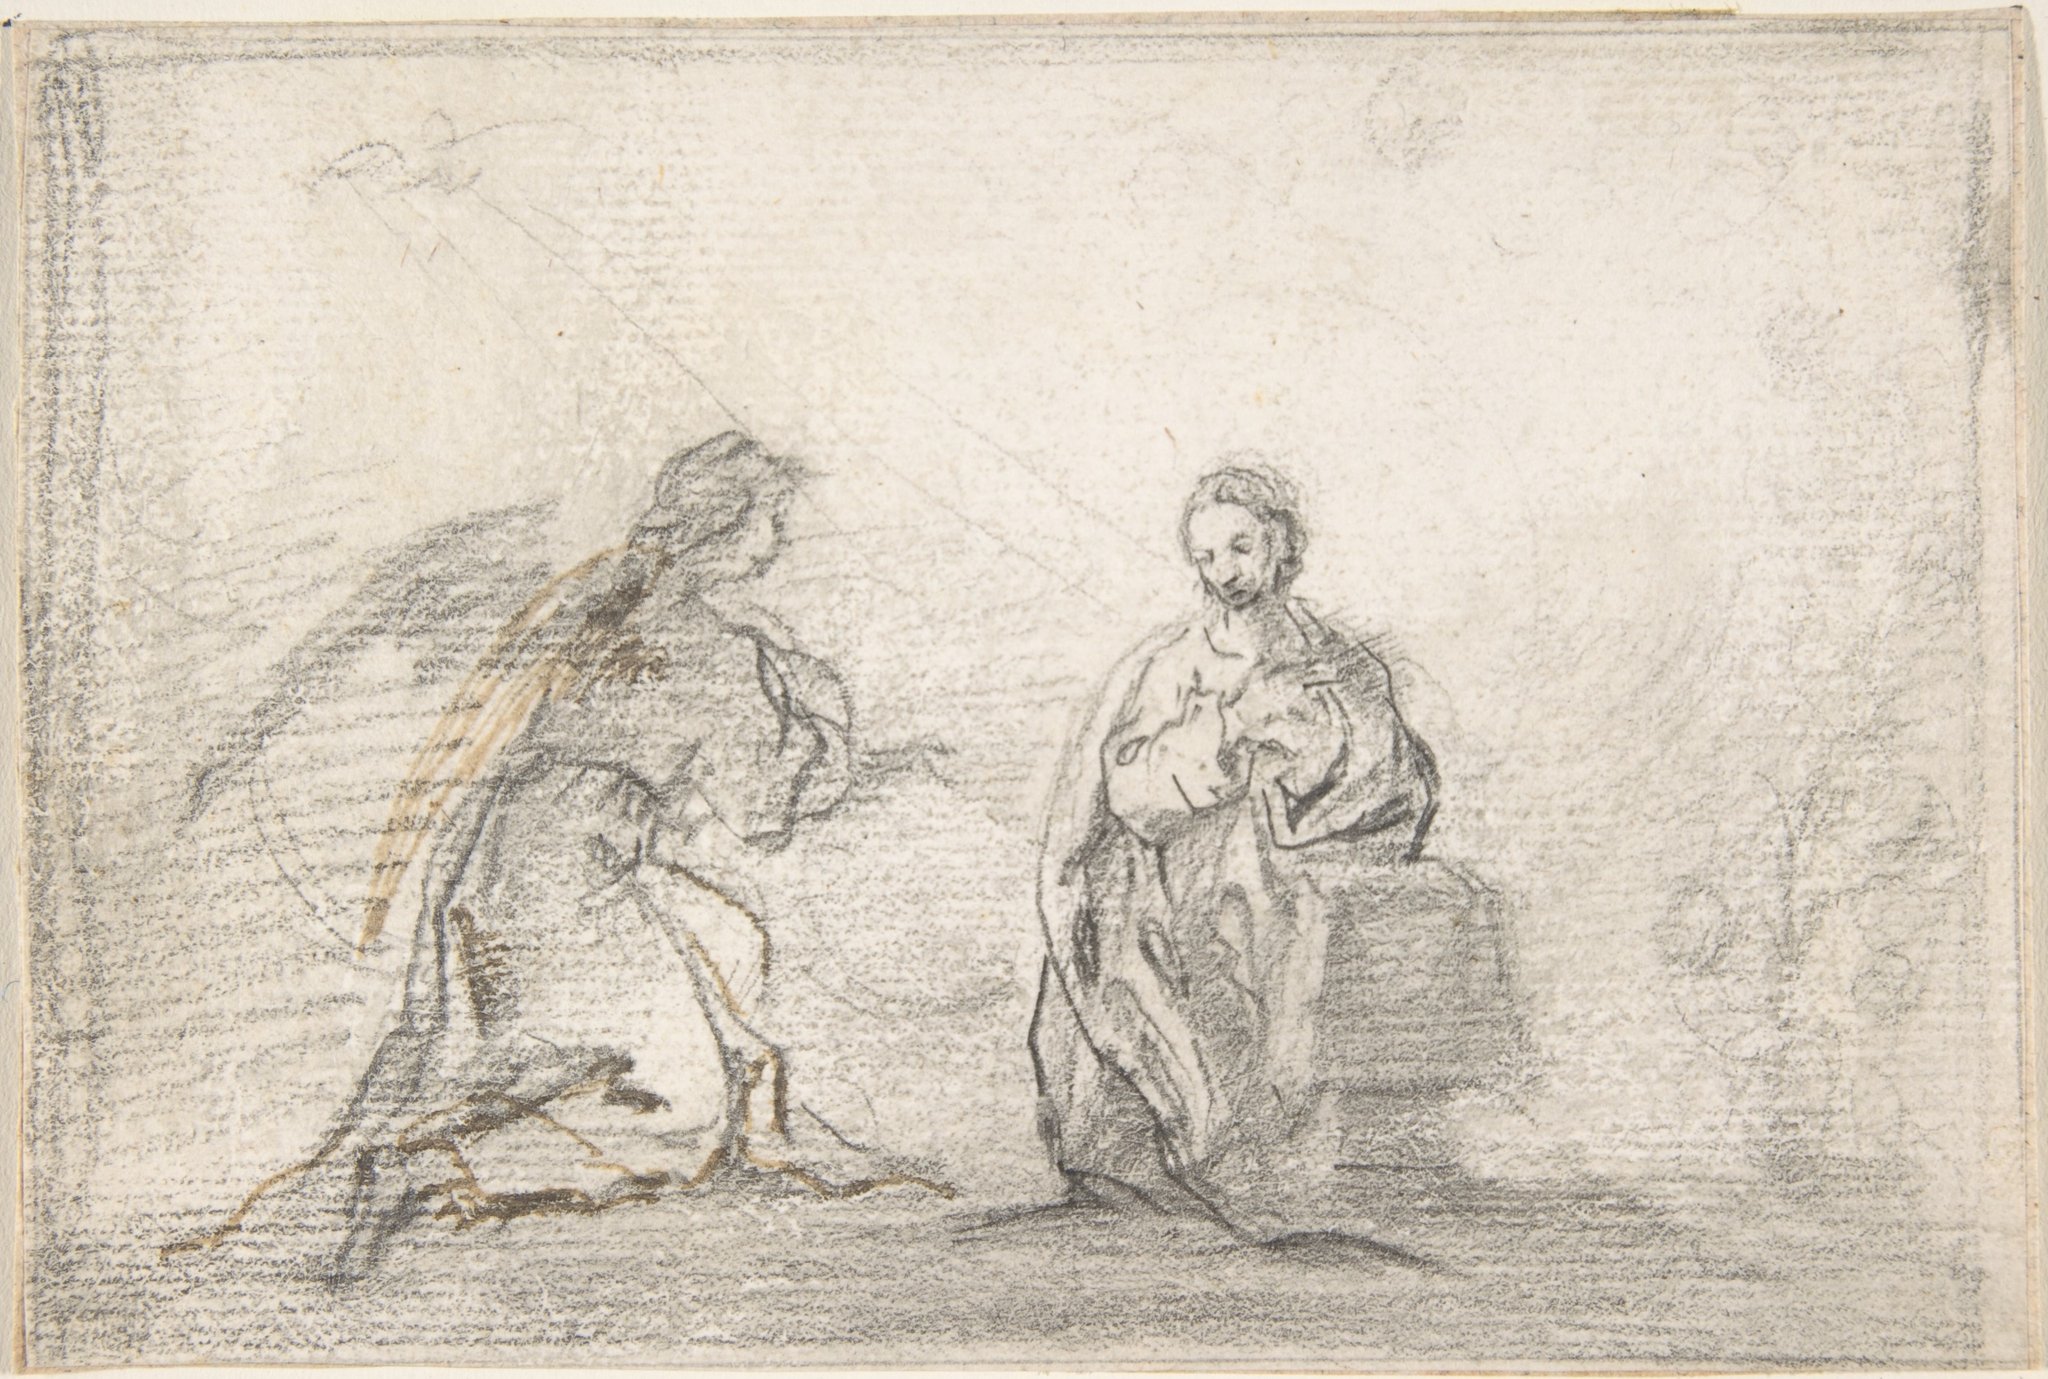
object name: drawing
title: The Annunciation (Angel Approaching from Left)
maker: pedro duque cornejo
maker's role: artist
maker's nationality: spanish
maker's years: 1677-1757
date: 1700-1750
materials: chalk, ink, paper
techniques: pen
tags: angels,annunciation